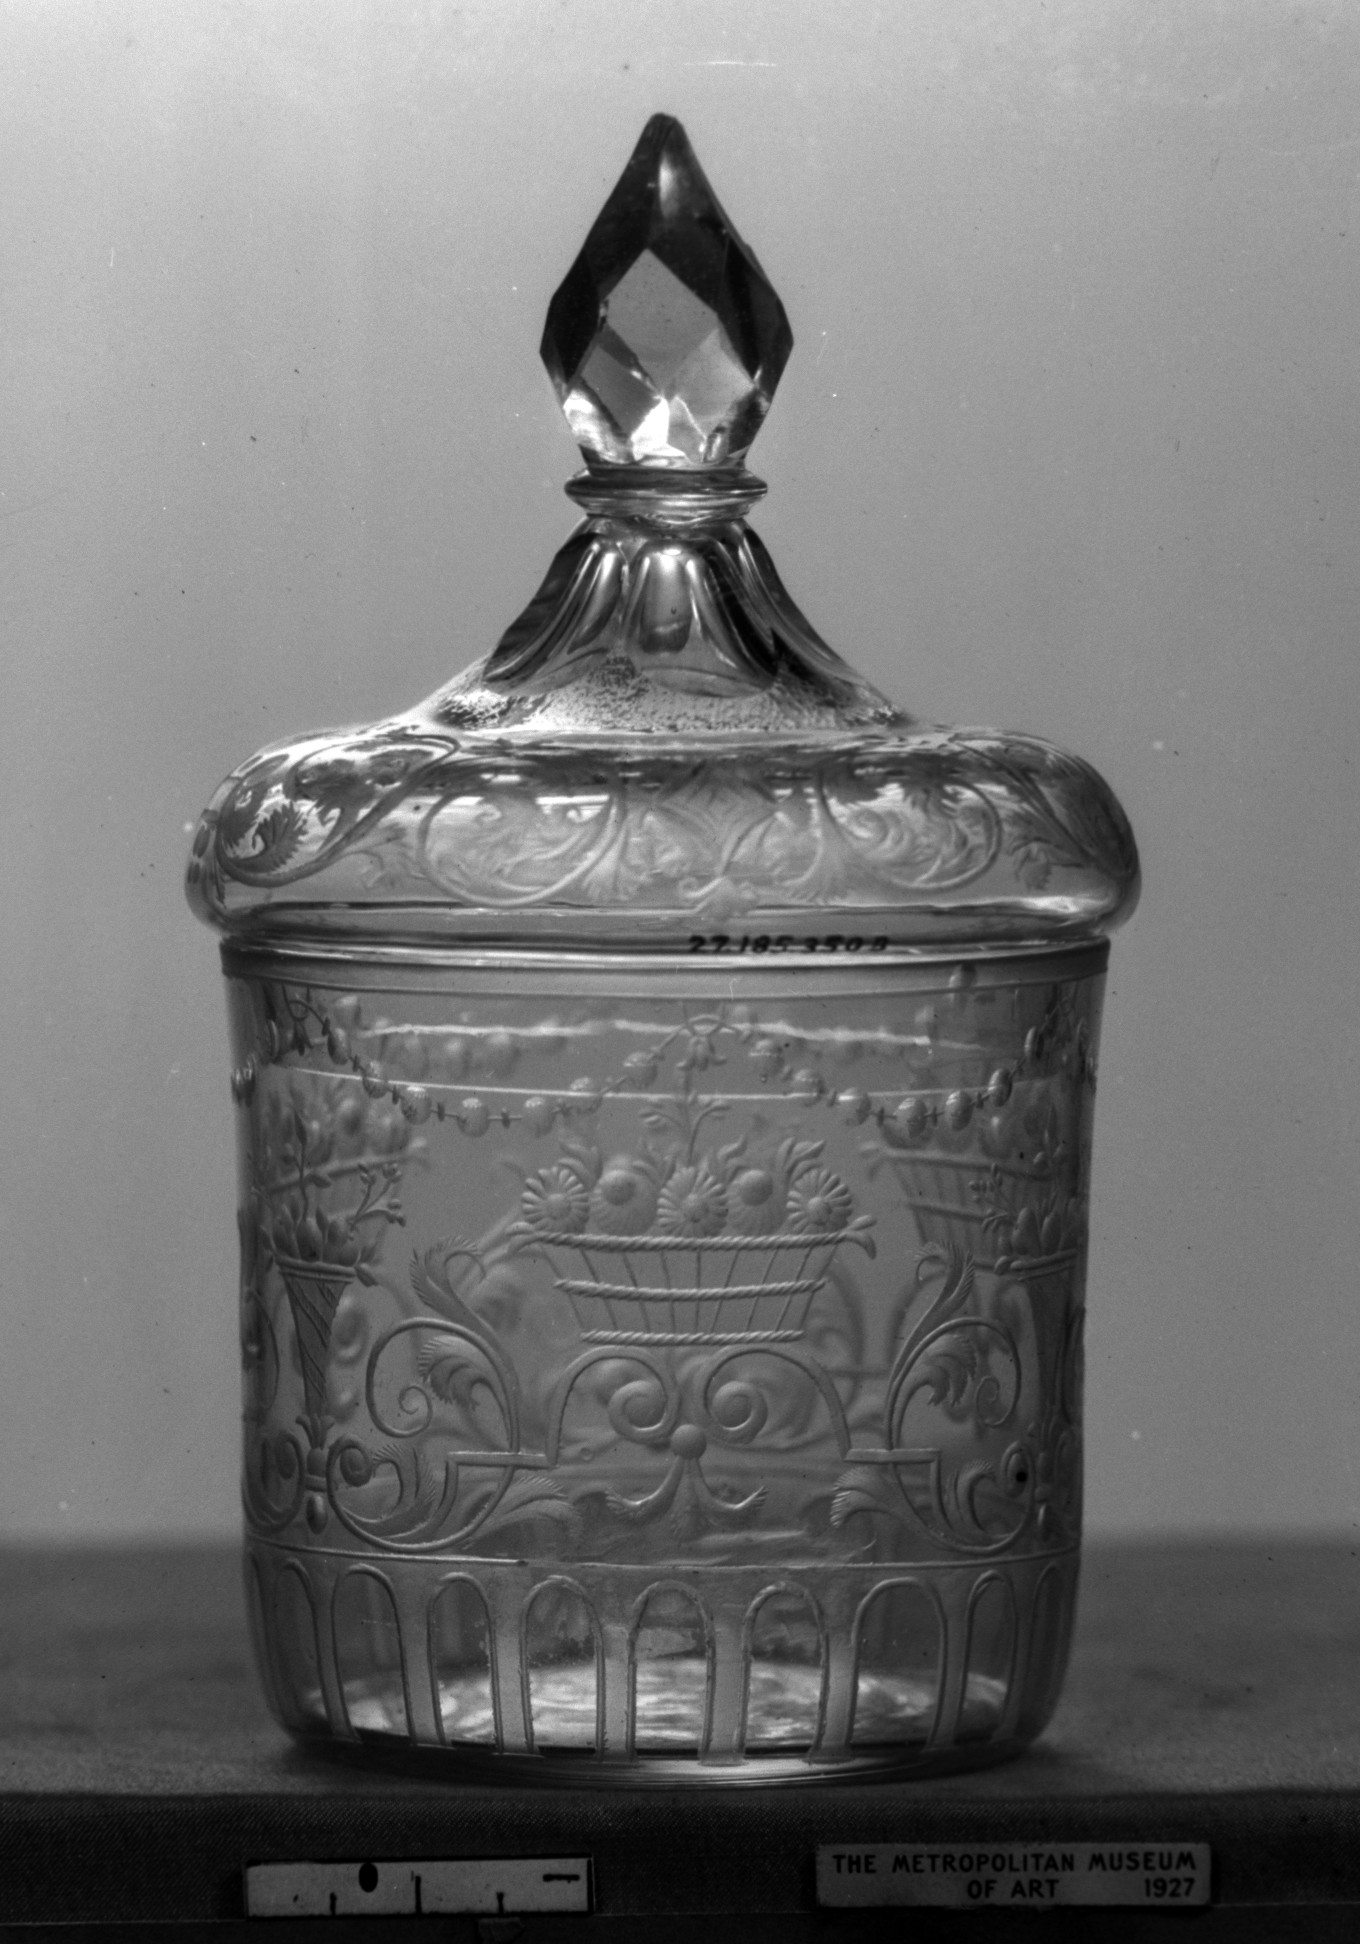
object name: jar with cover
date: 1730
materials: glass